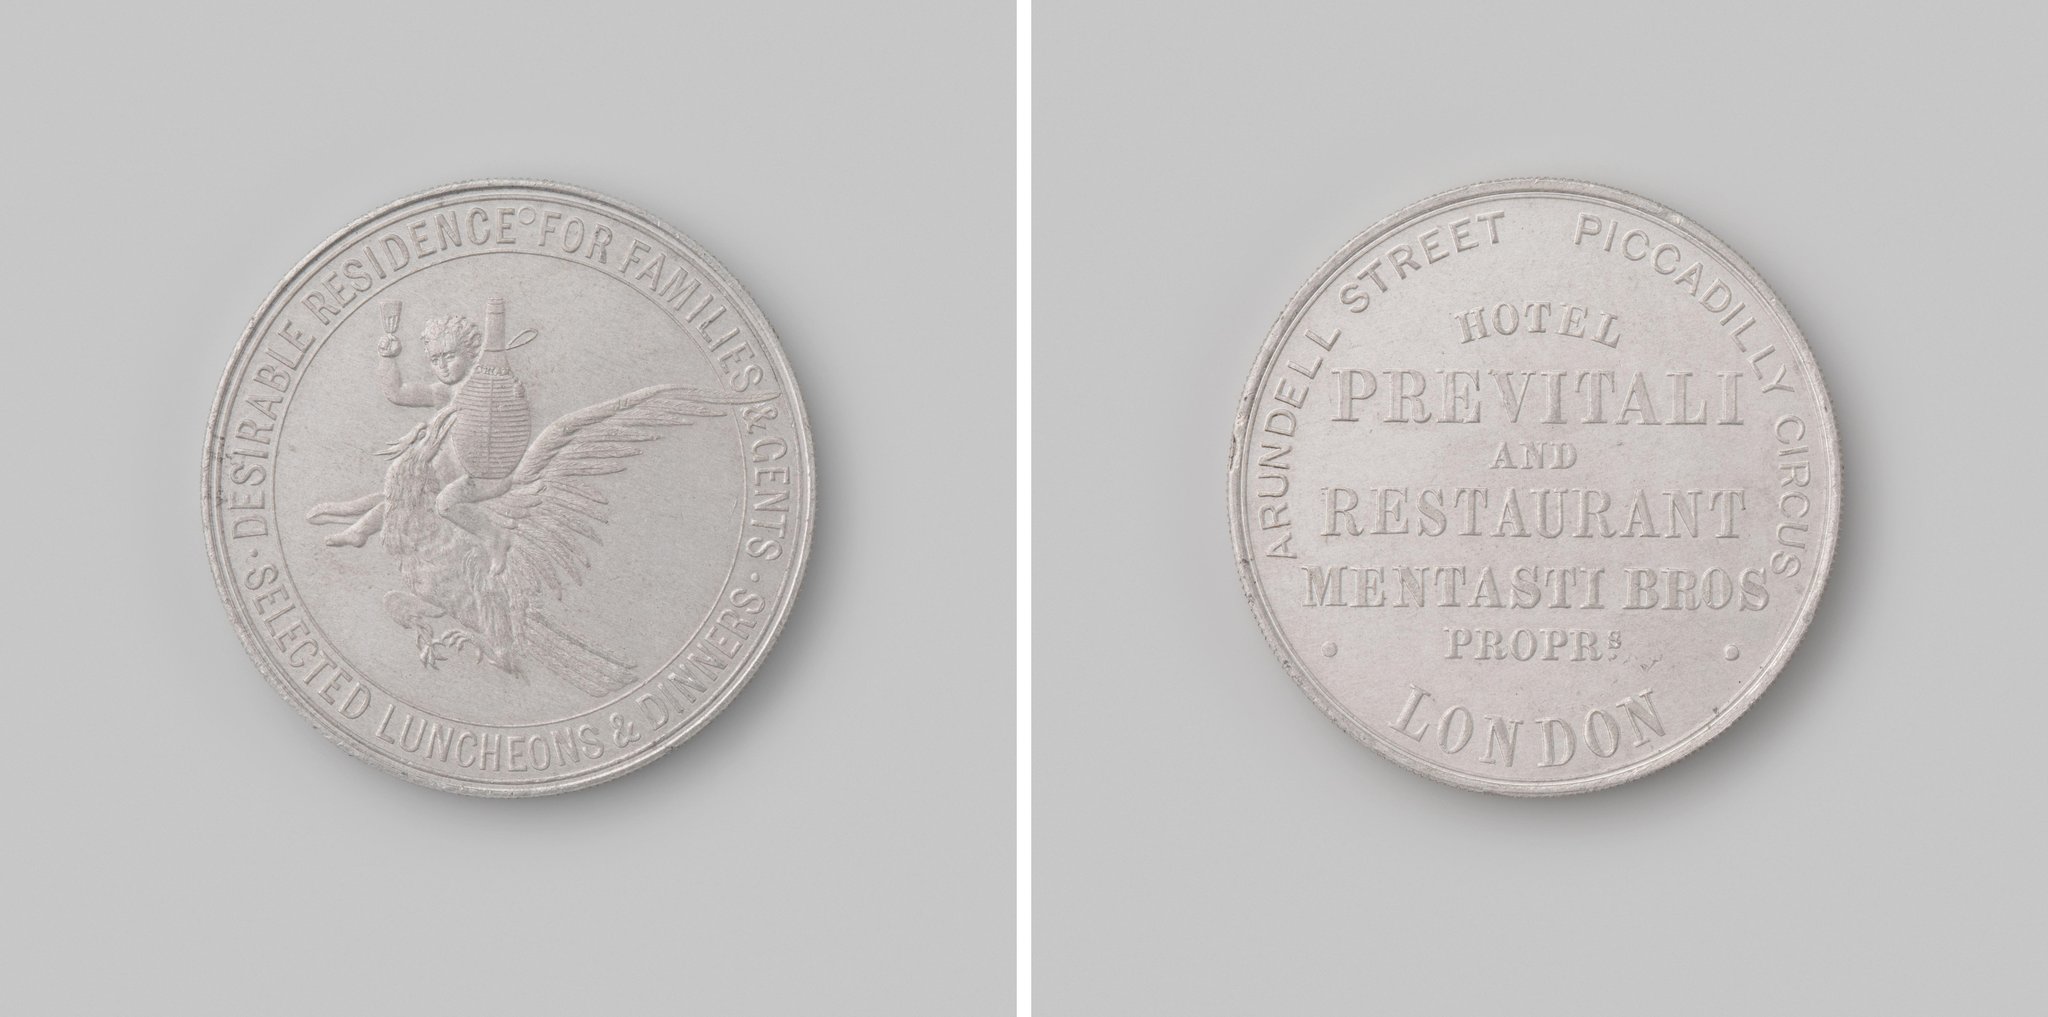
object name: history medal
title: Engelse reclamepenning voor Hotel Previtali te Londen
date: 1870-1930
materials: aluminum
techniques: striking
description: Aluminium penning, op de voorzijde een omziende vliegende adelaar waarop een jongetje met chiantifles en wijnglas, met omschrift, op de keerzijde zes regels tekst met omschrift.